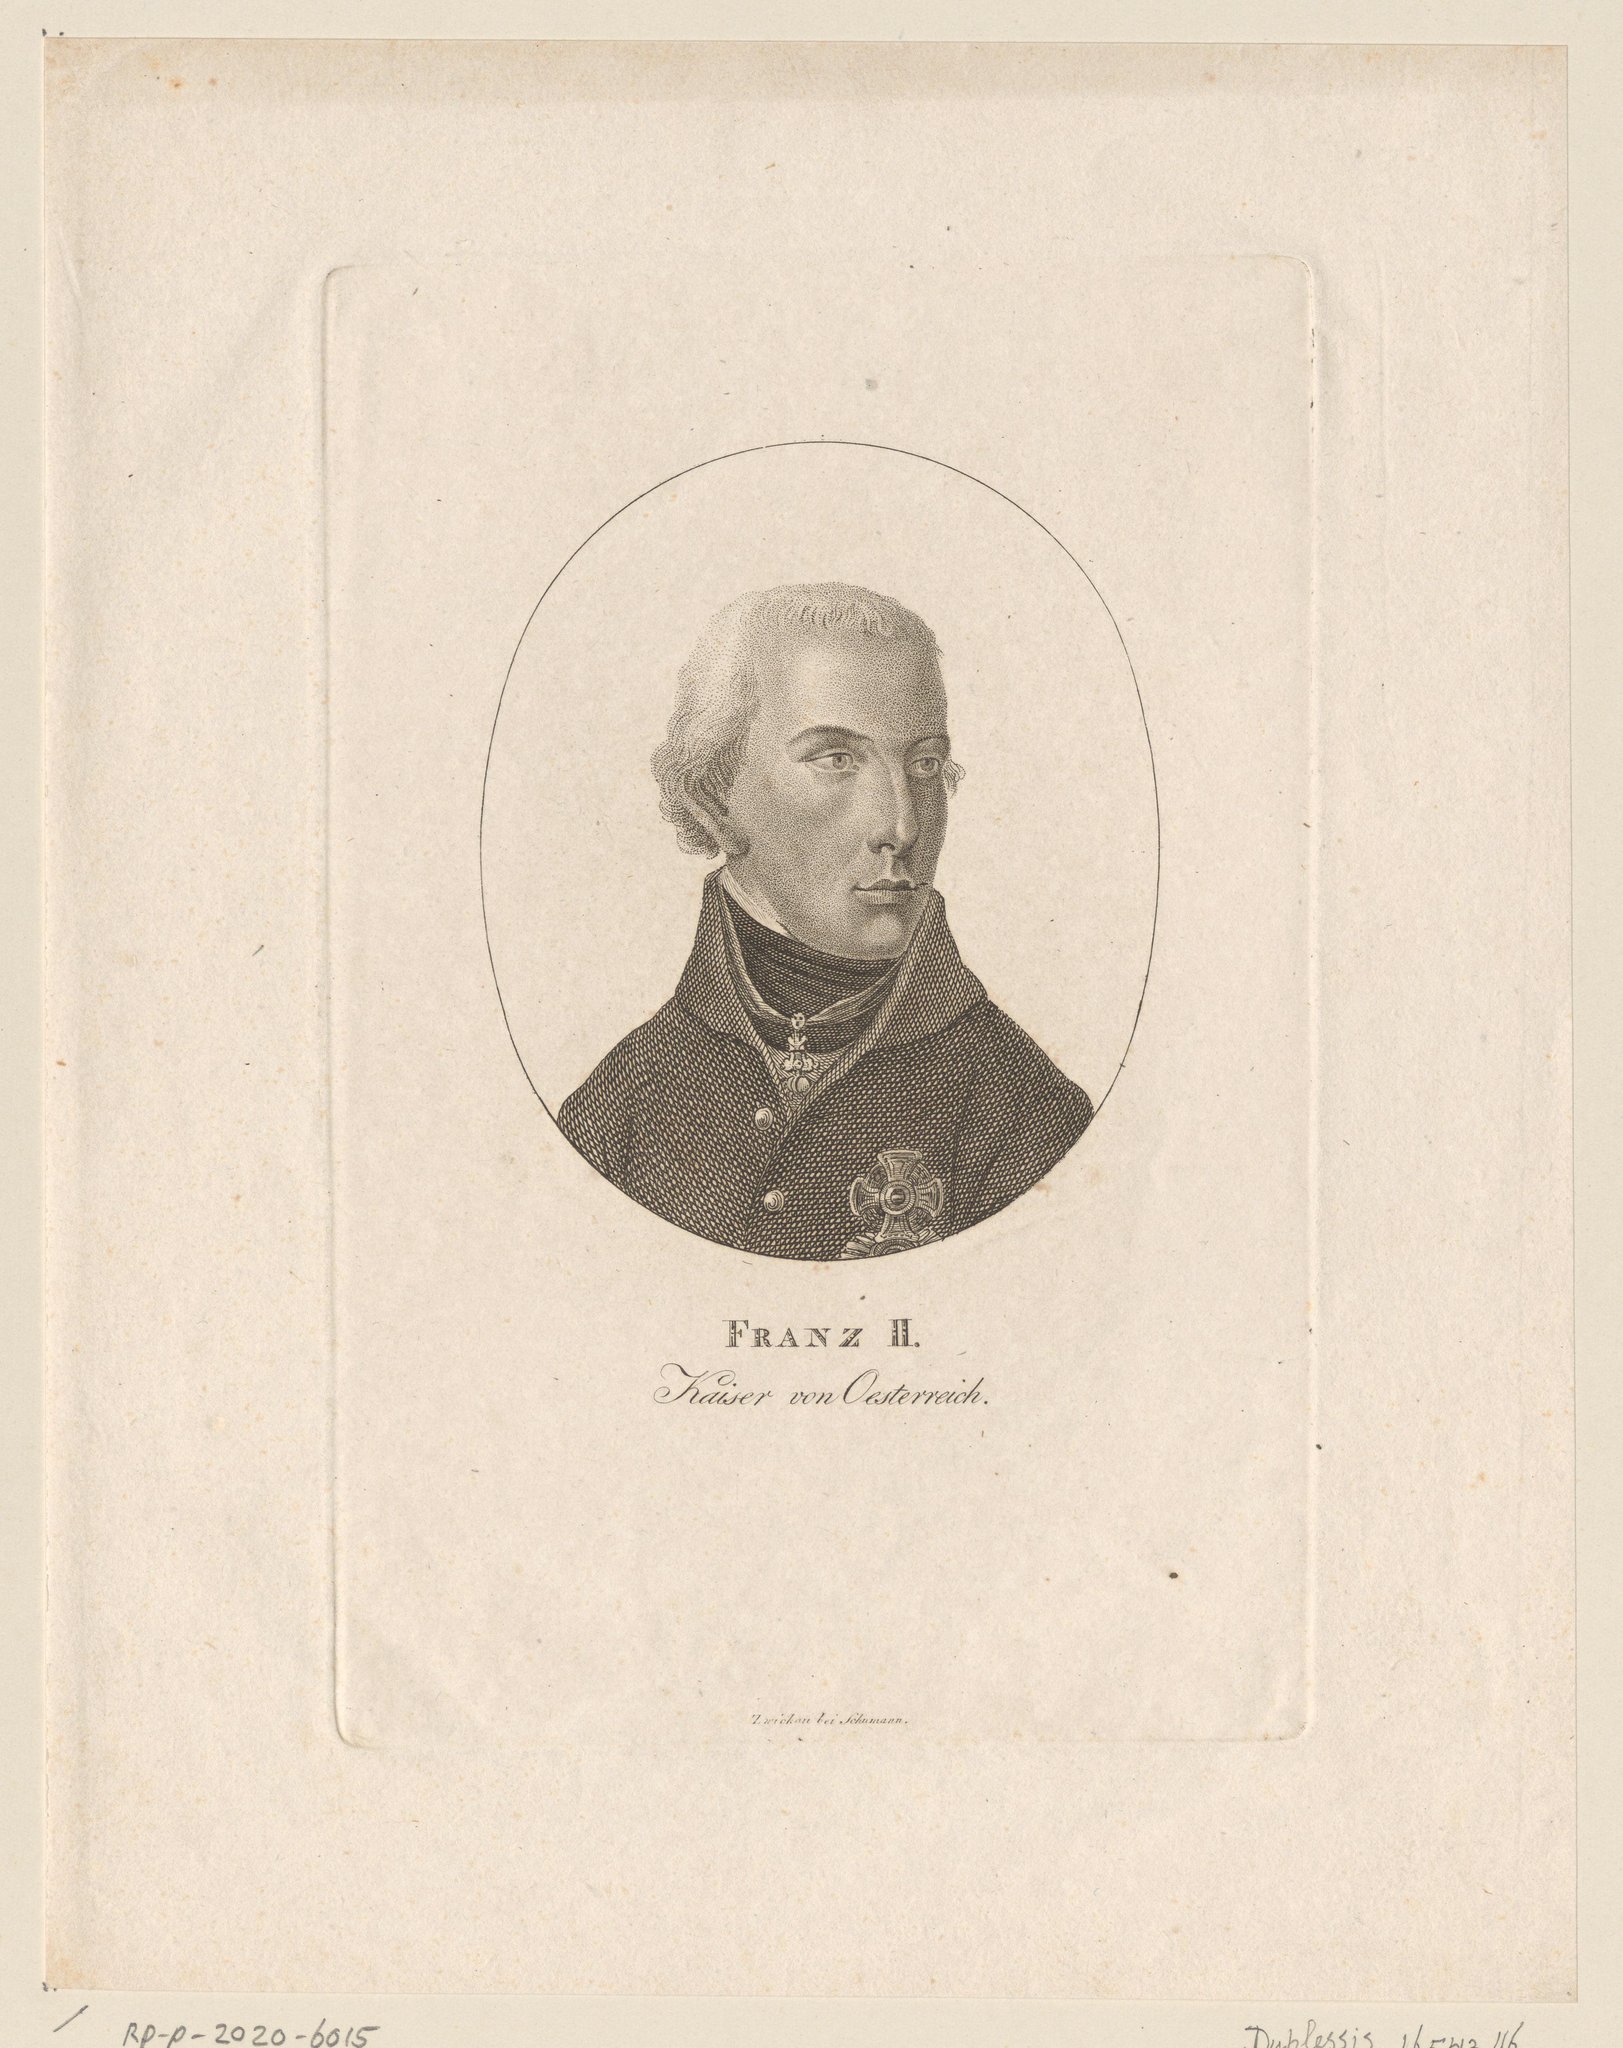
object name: print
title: Portret van Frans I, keizer van Oostenrijk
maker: Anonymous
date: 1804-1835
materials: paper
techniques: etching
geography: zwickau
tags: vienna, frans ii (rooms-duits keizer), historical persons, emperor